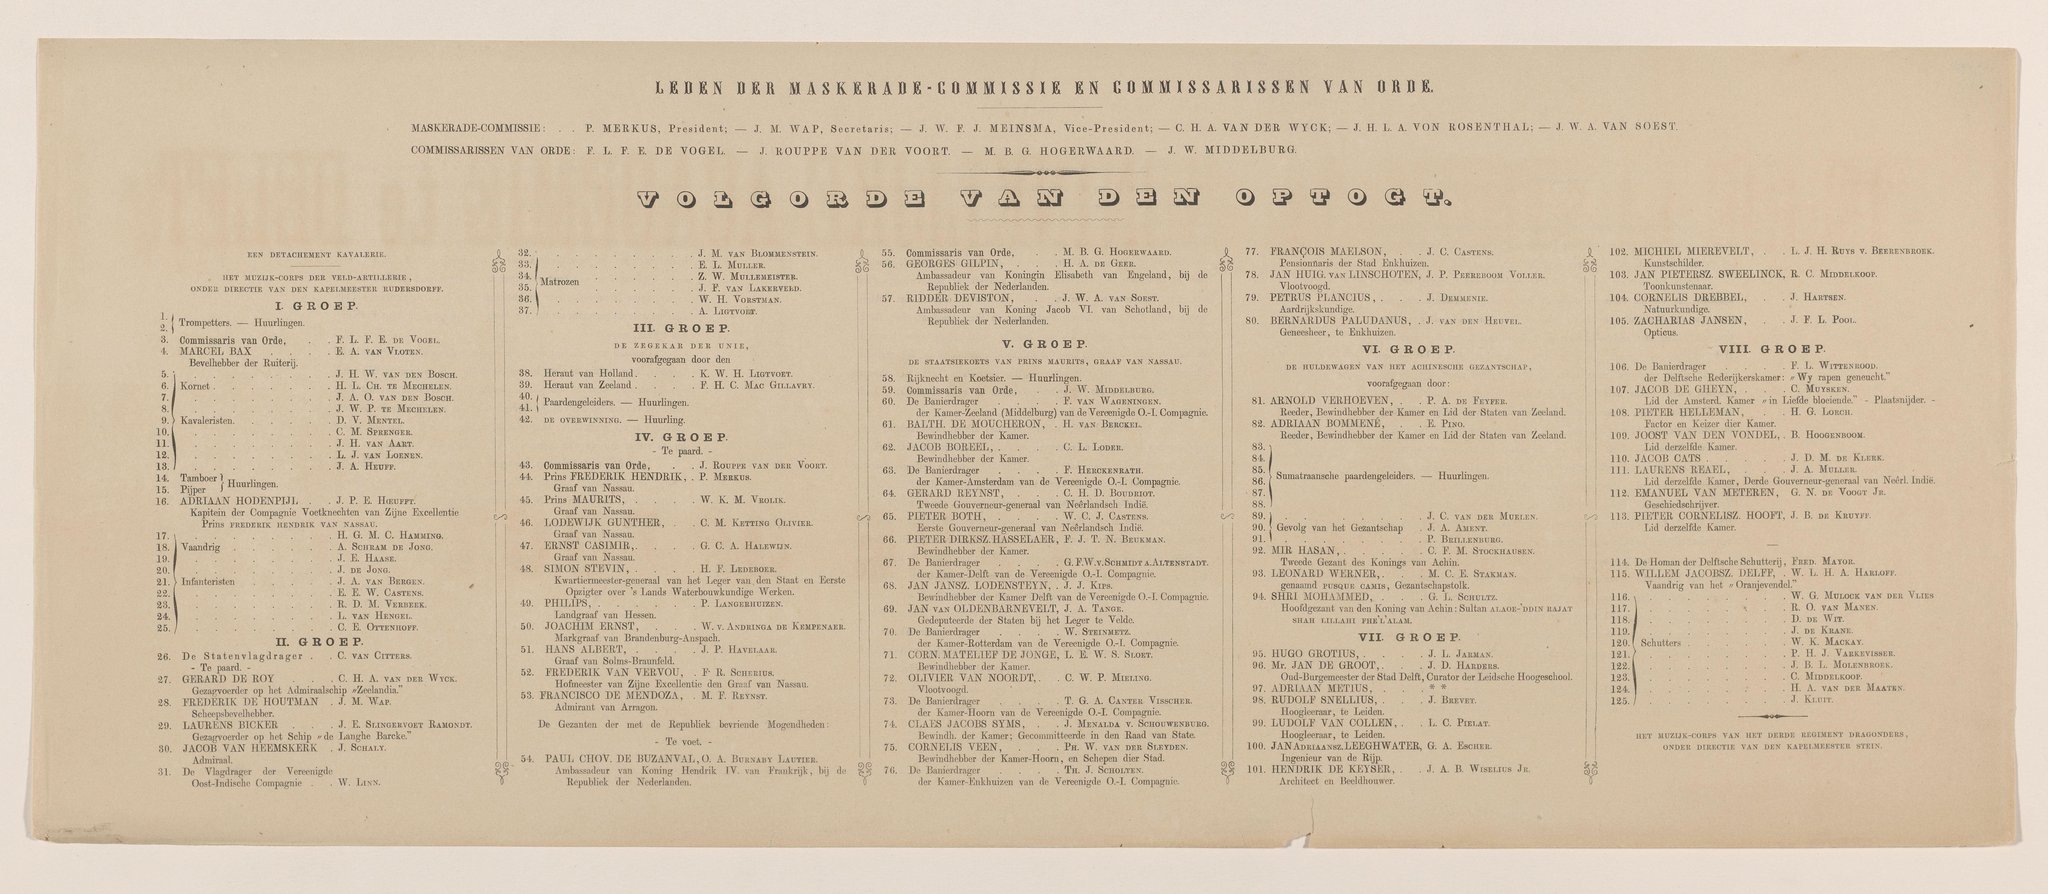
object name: print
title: Namenlijst van groepen in Delftse optocht van 1862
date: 1862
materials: paper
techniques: letterpress printing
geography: delft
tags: university, students' pageant, commemoration of the founding of a university, delft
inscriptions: collector's mark: Lugt 2228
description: Verklaring met de namen en rollen van de deelnemers van de acht groepen in de optocht. De stoet stelt het gezantschap van de sultan van Atjeh aan prins Maurits en de Staten op 4 september 1602 voor.Onderdeel van een omslag met een serie van acht lithografieën van de Delftse optocht van 1862.